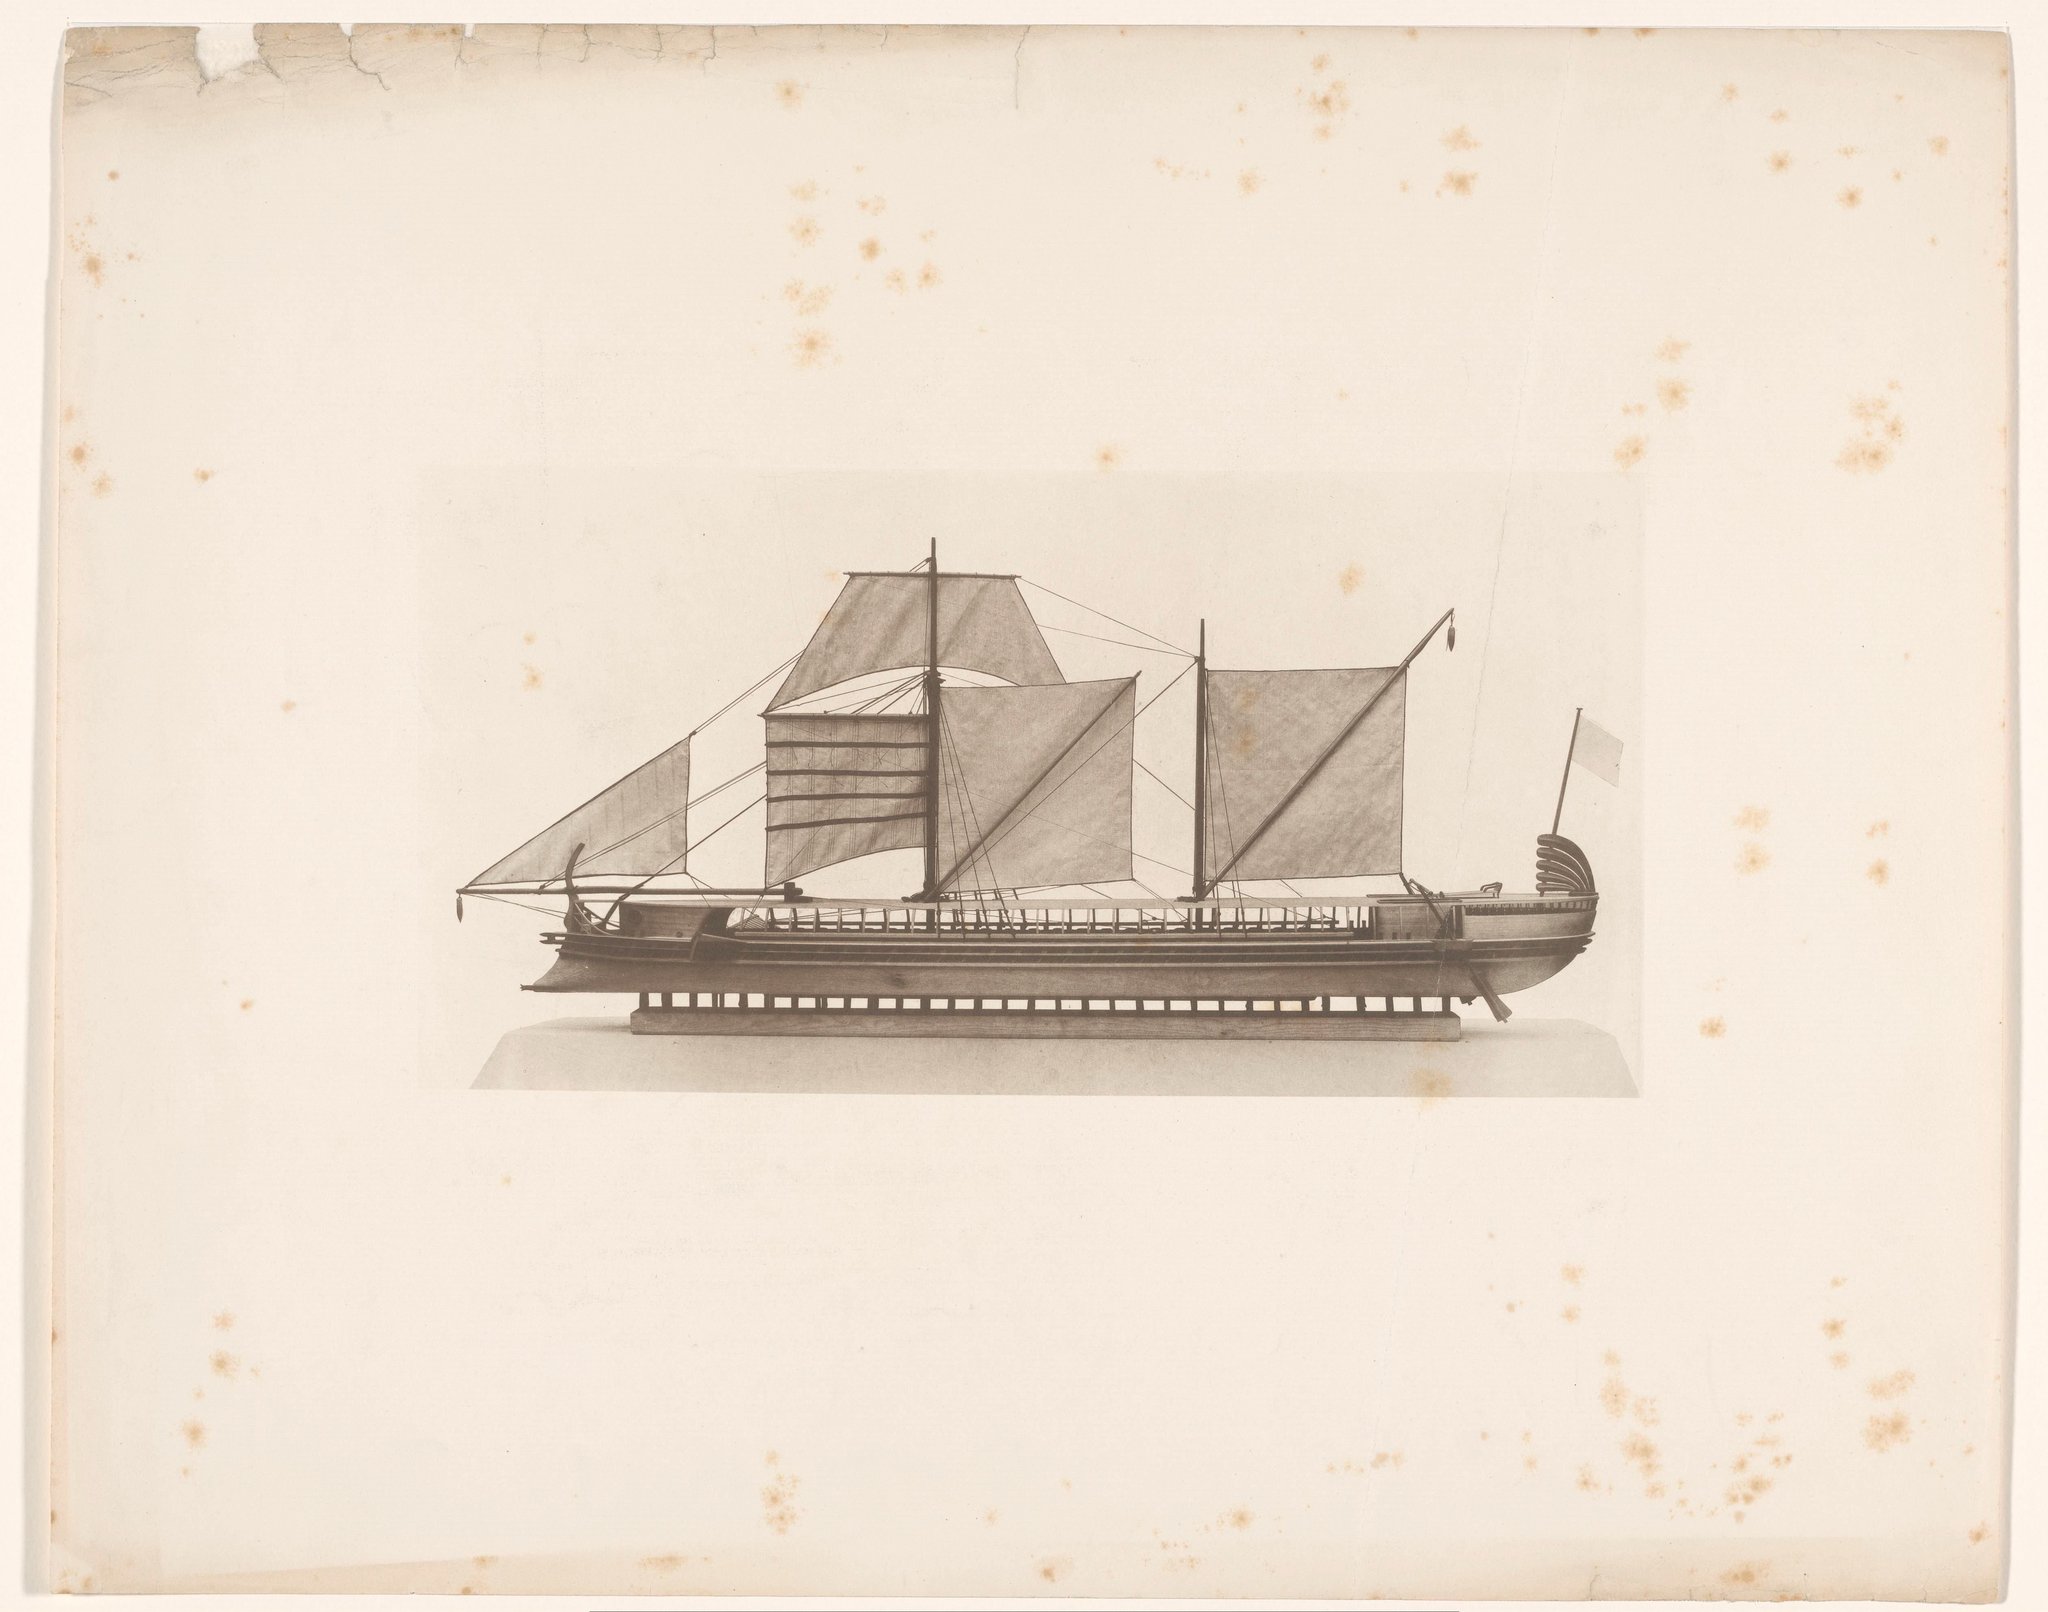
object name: print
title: Scheepsmodel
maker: Anonymous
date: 1870-1920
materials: ink, paper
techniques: lithograph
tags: sailing-ship, sailing-boat, ship-model